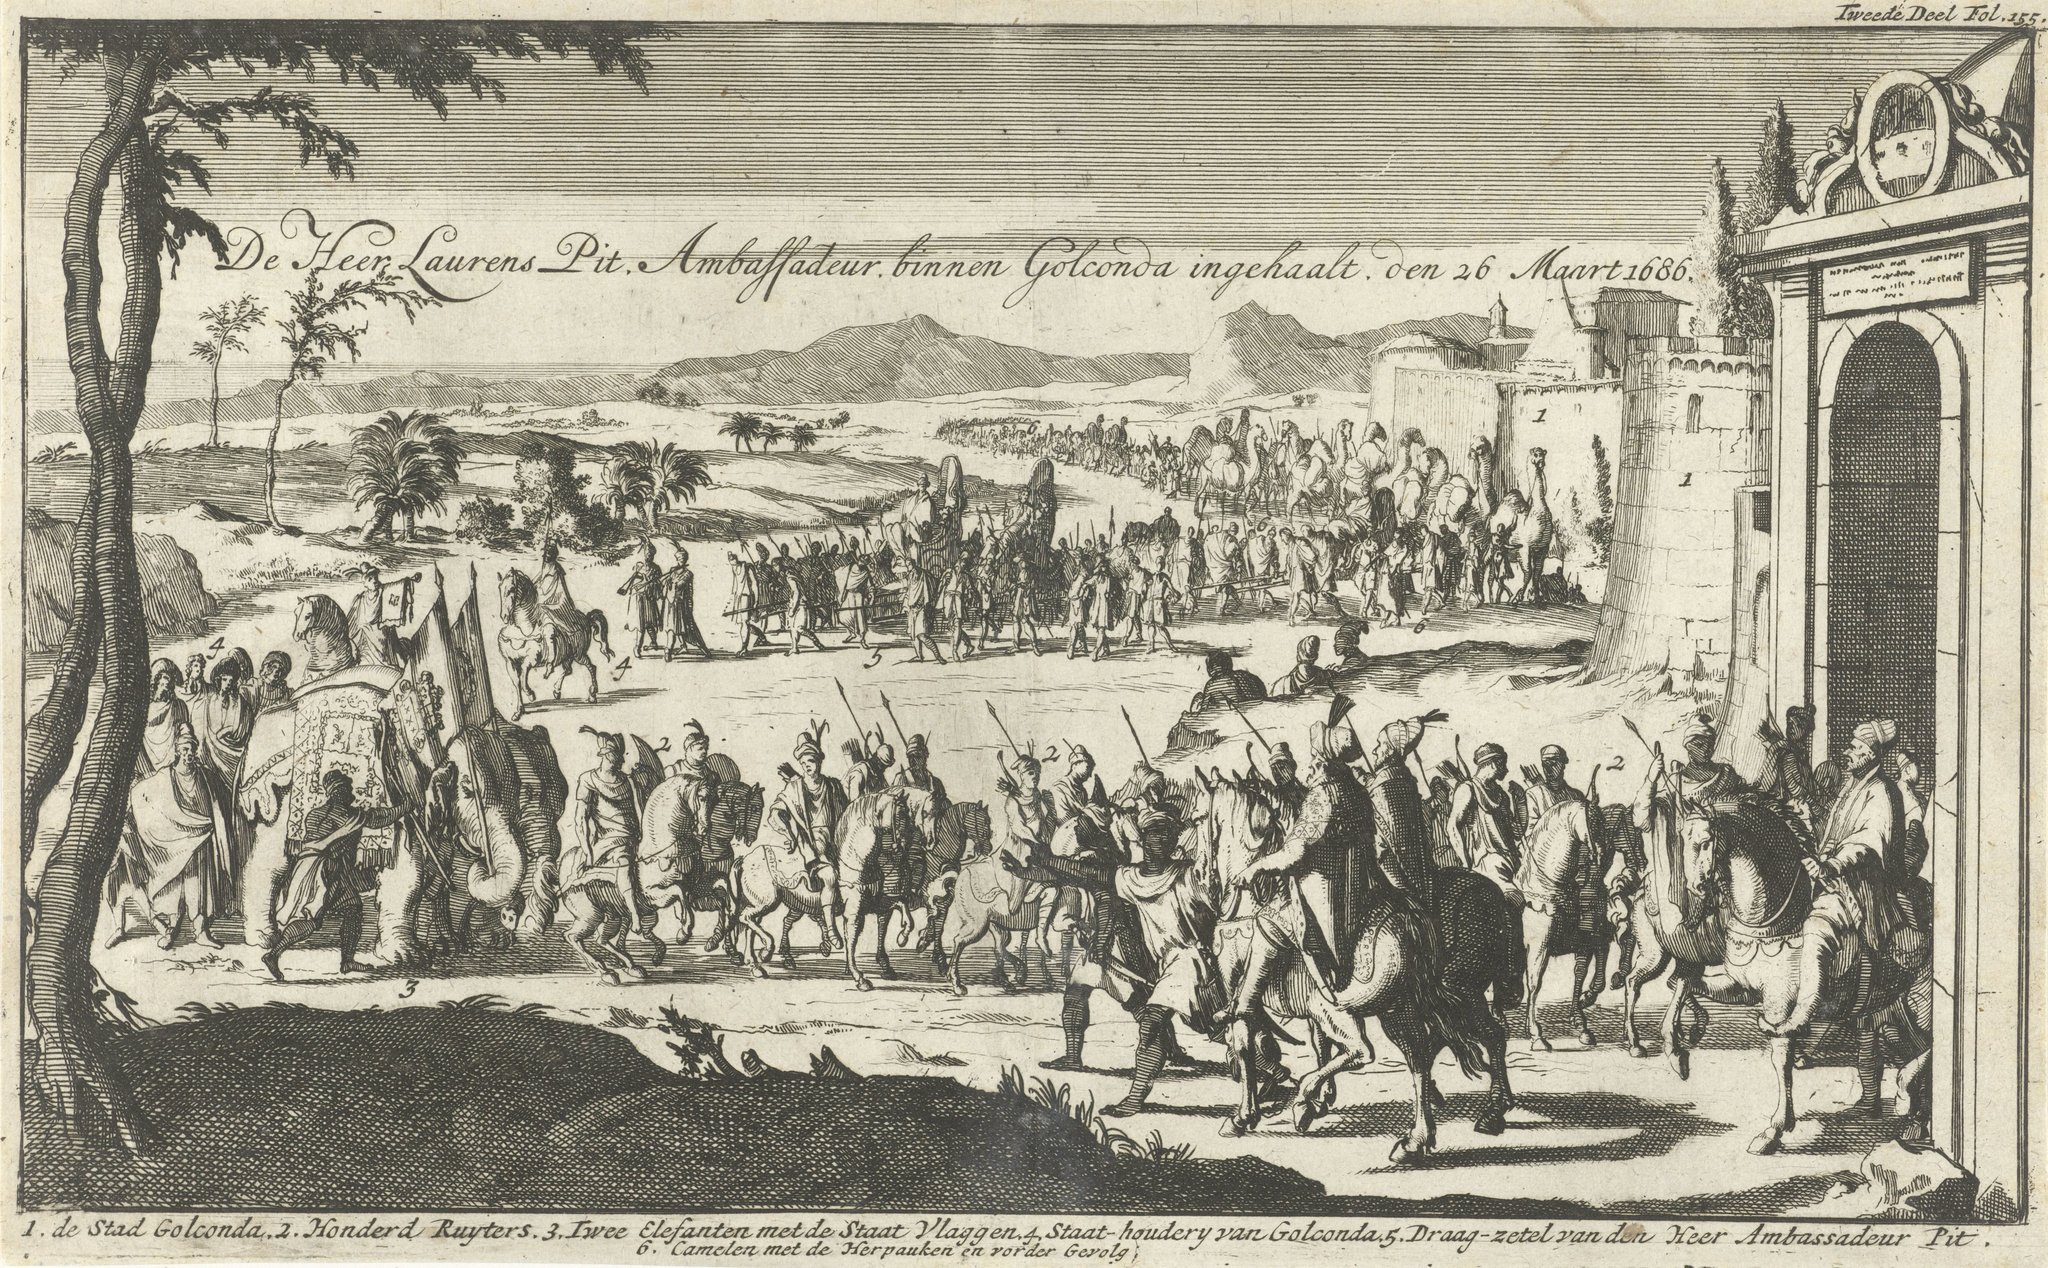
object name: book illustration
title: Gouverneur Laurens Pit de Jonge wordt ontvangen in Golkonda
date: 1693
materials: paper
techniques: etching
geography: amsterdam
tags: festivities (+ parade, pageant, cavalcade ~ festive activities)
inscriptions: collector's mark: Lugt 2228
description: Illustratie uit: Havart, Daniël. Op- en ondergang van Cormandel, 2 delen. Amsterdam: Jan Claesz ten Hoorn, 1693.